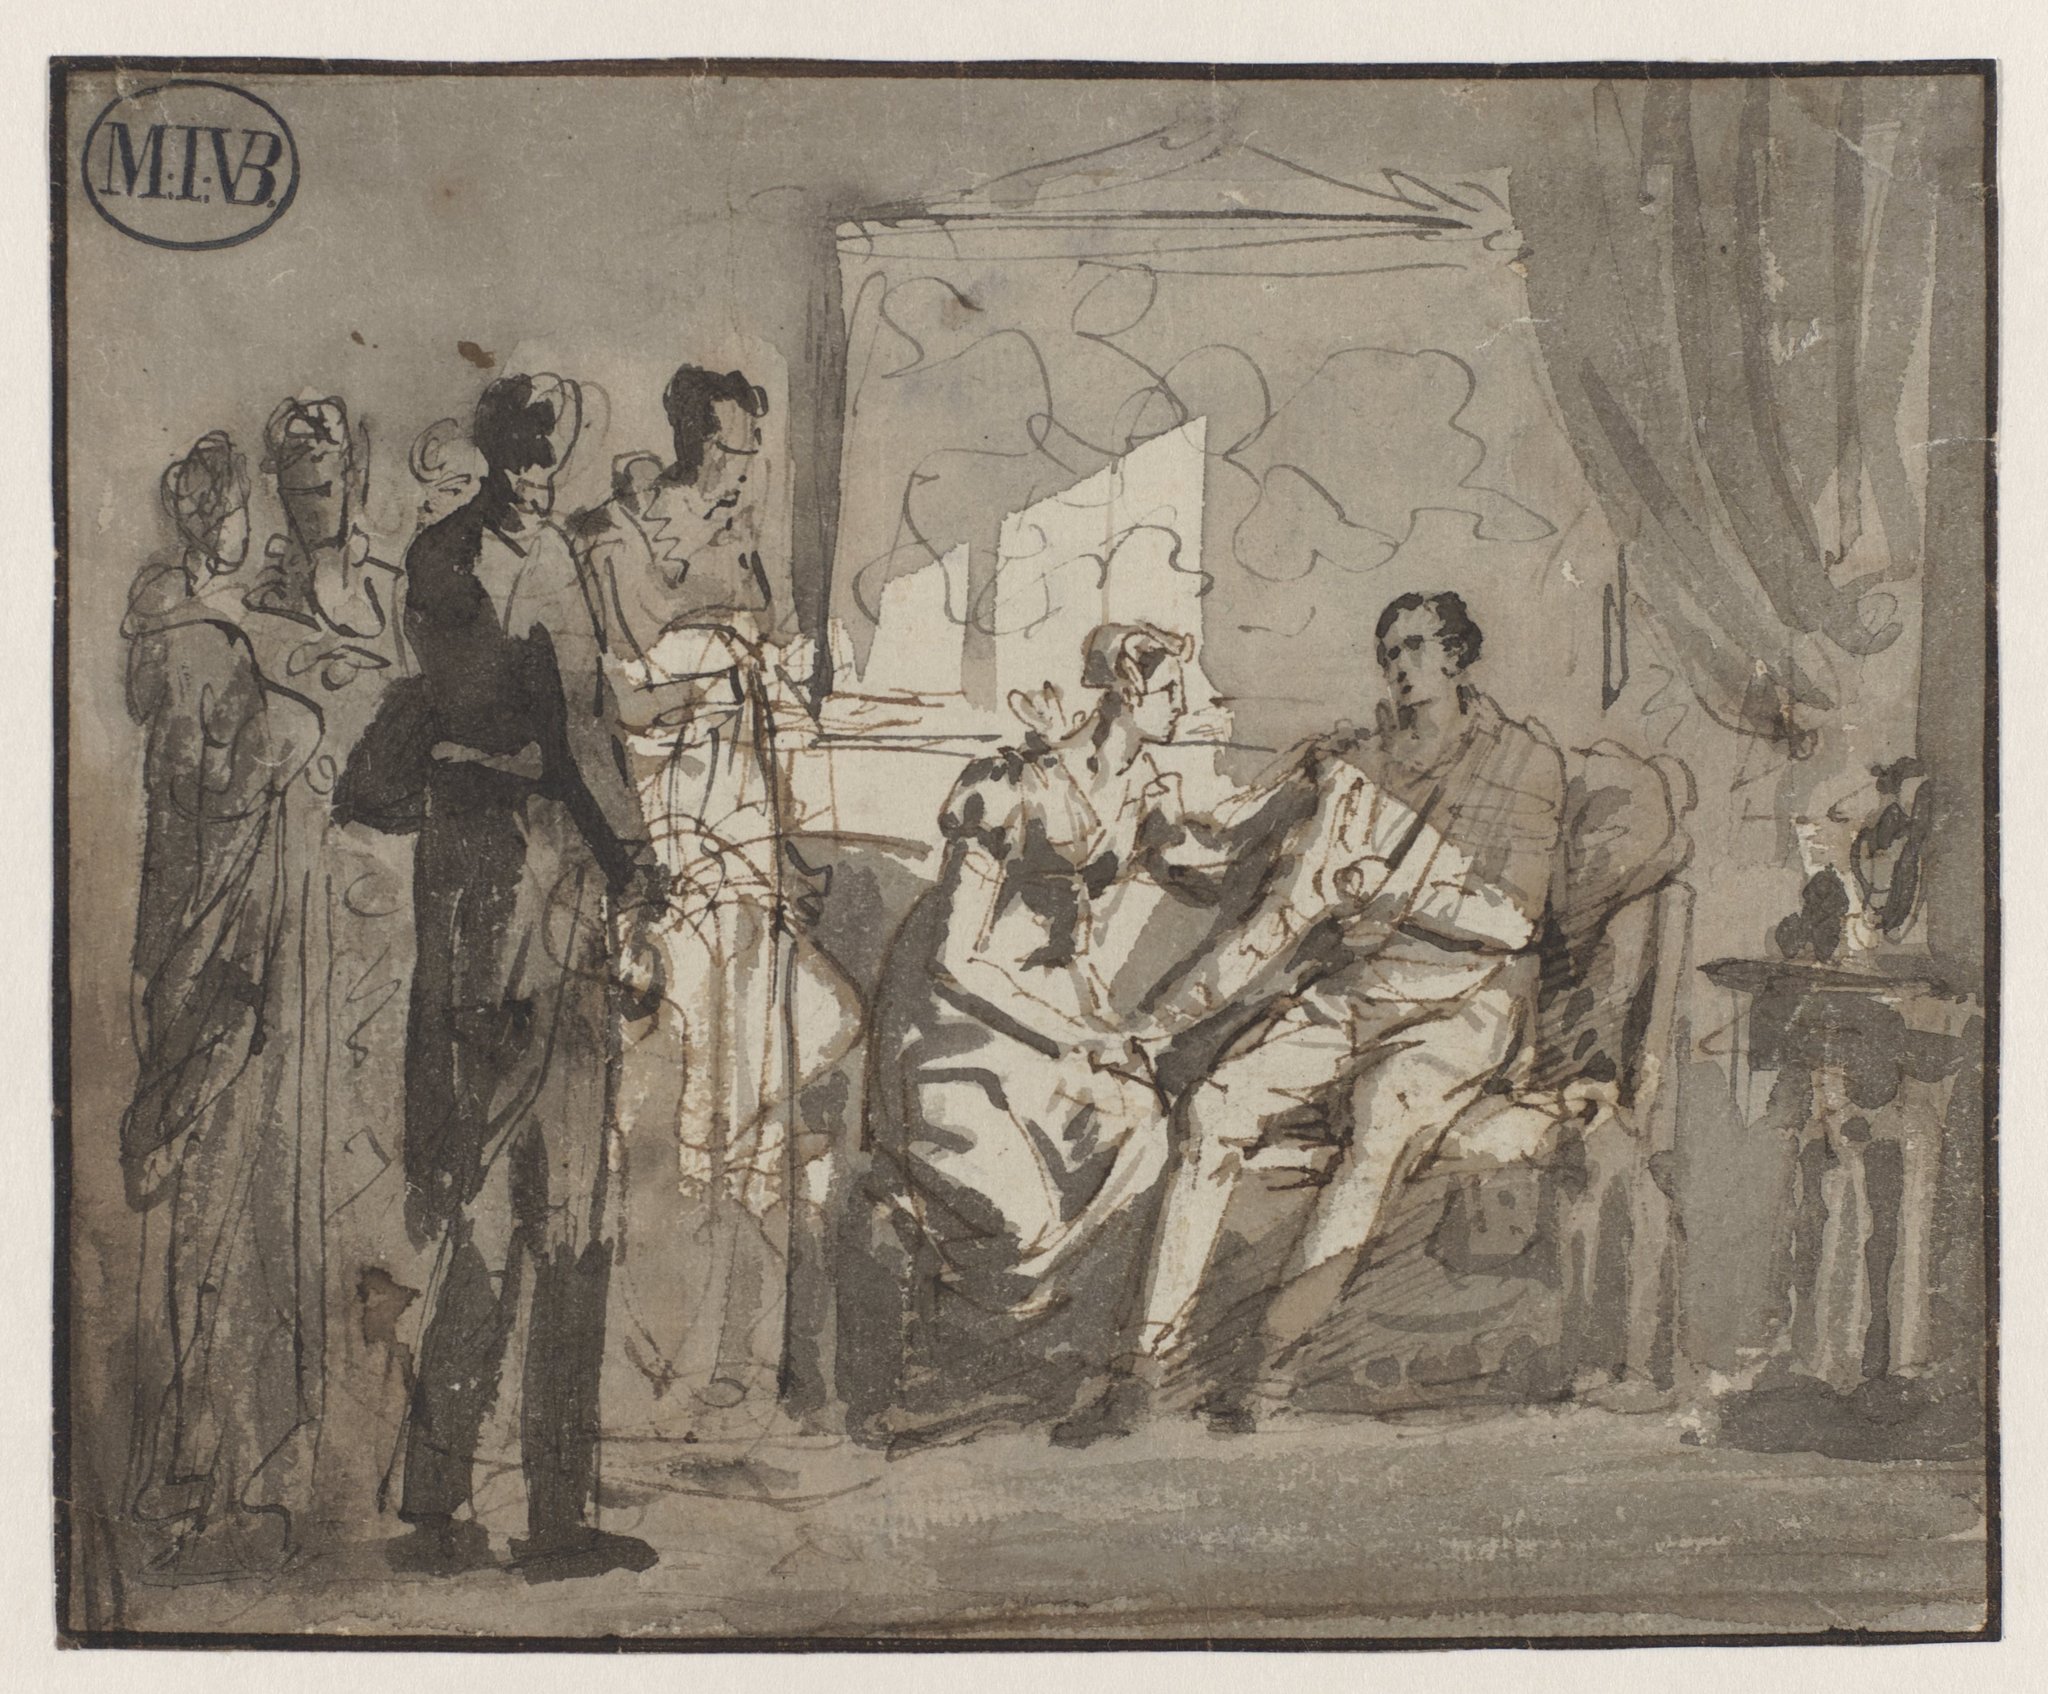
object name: drawing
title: Koningin Wilhelmina bezoekt de gewonde Prins van Oranje, na de slag bij Waterloo, in Brussel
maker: mattheus ignatius van bree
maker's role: draughtsman, print maker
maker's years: 1773-1839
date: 1815-1817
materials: ink, paper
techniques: brush, pen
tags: the hague, william ii of the netherlands, berlin, wilhelmina frederica louisa (koningin der nederlanden), historical persons, visiting the sick; sick person together with others, historical events and situations